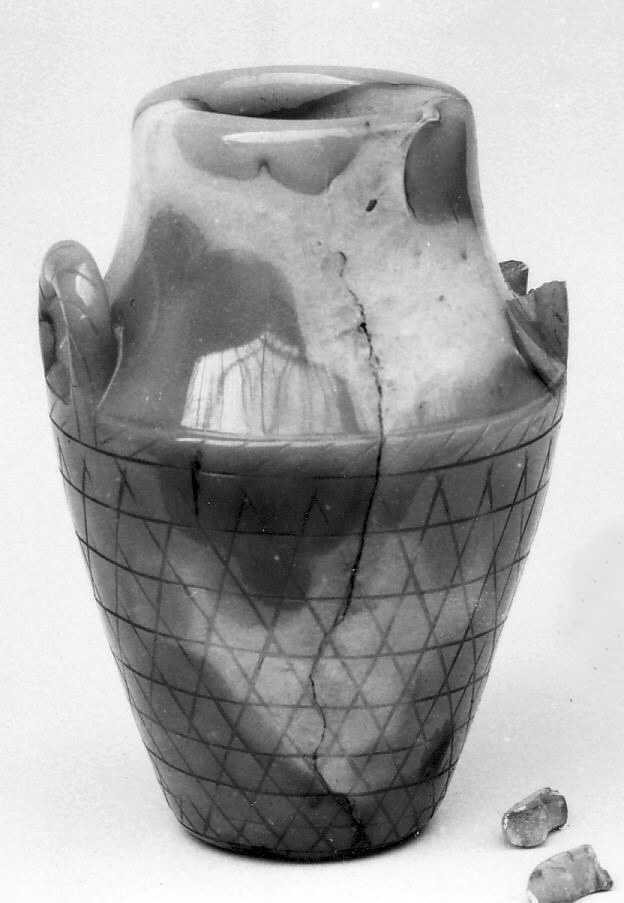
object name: vase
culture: chinese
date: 1801-1900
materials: stone